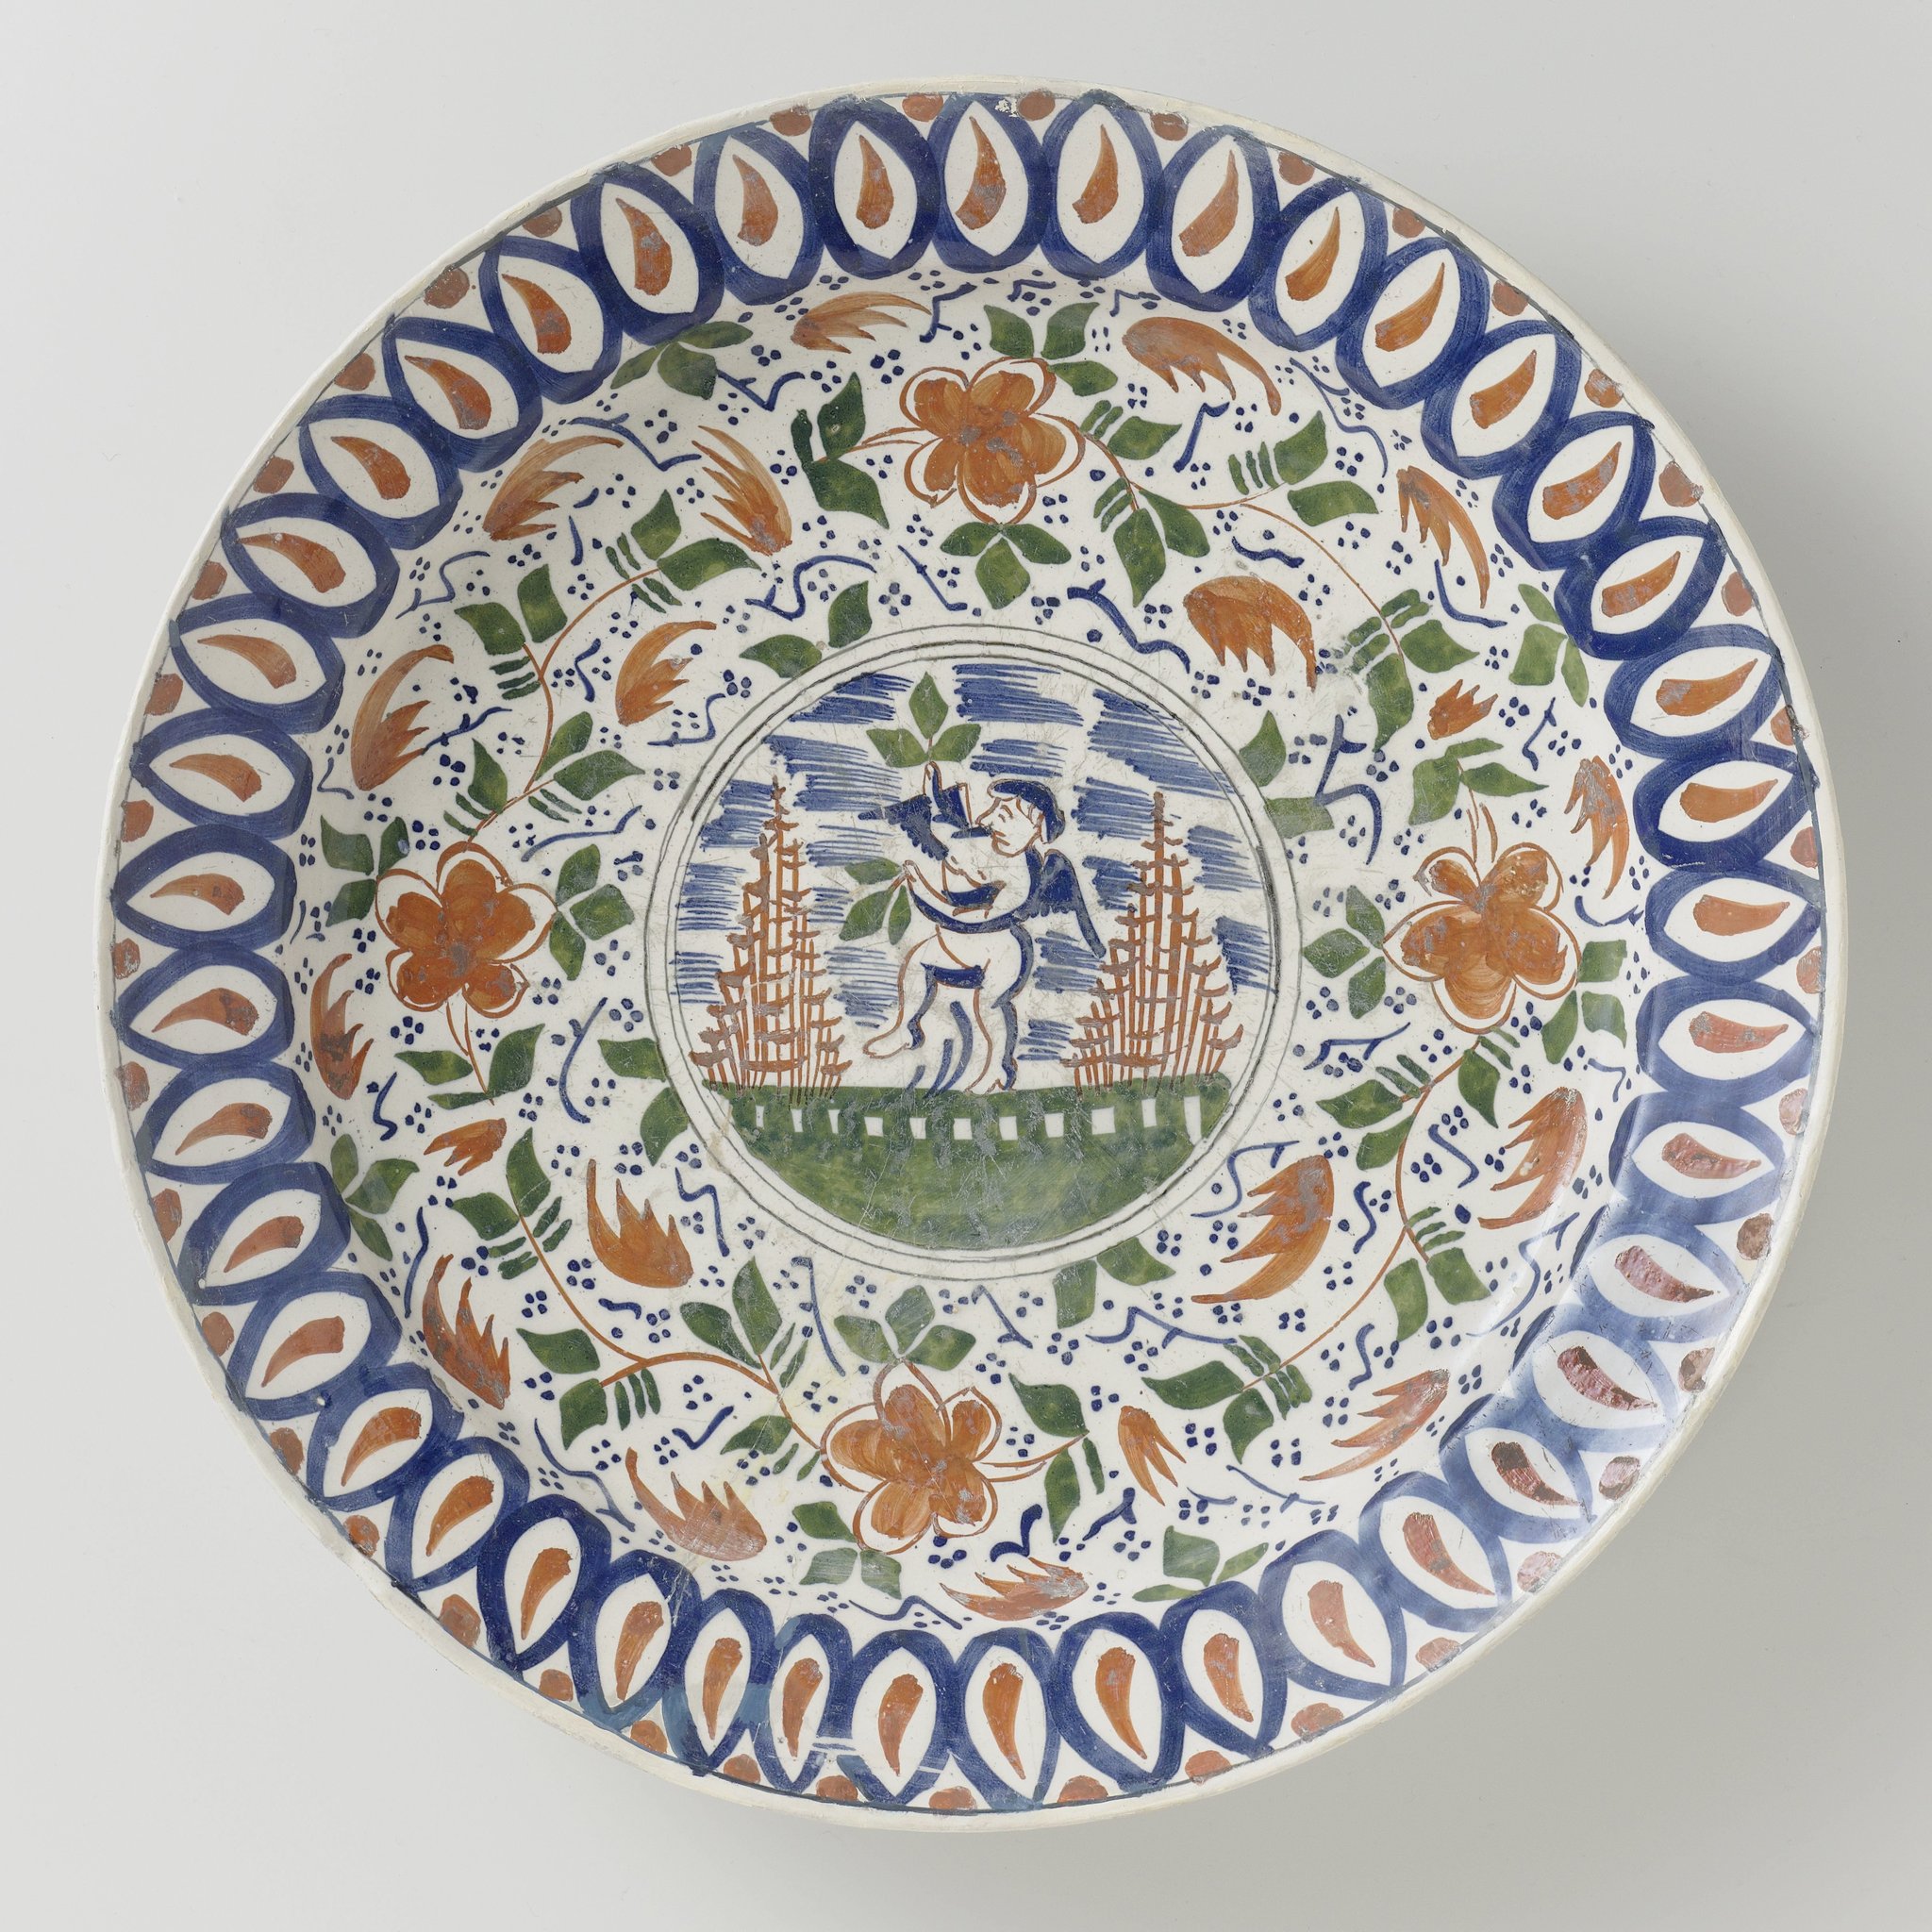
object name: platter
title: Schotel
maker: Anonymous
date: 1710-1750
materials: faience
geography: delft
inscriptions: inscription: ‘-511[...]’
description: Schotel van faience. Veelkleurig beschilderd met Cupido en bloemen.